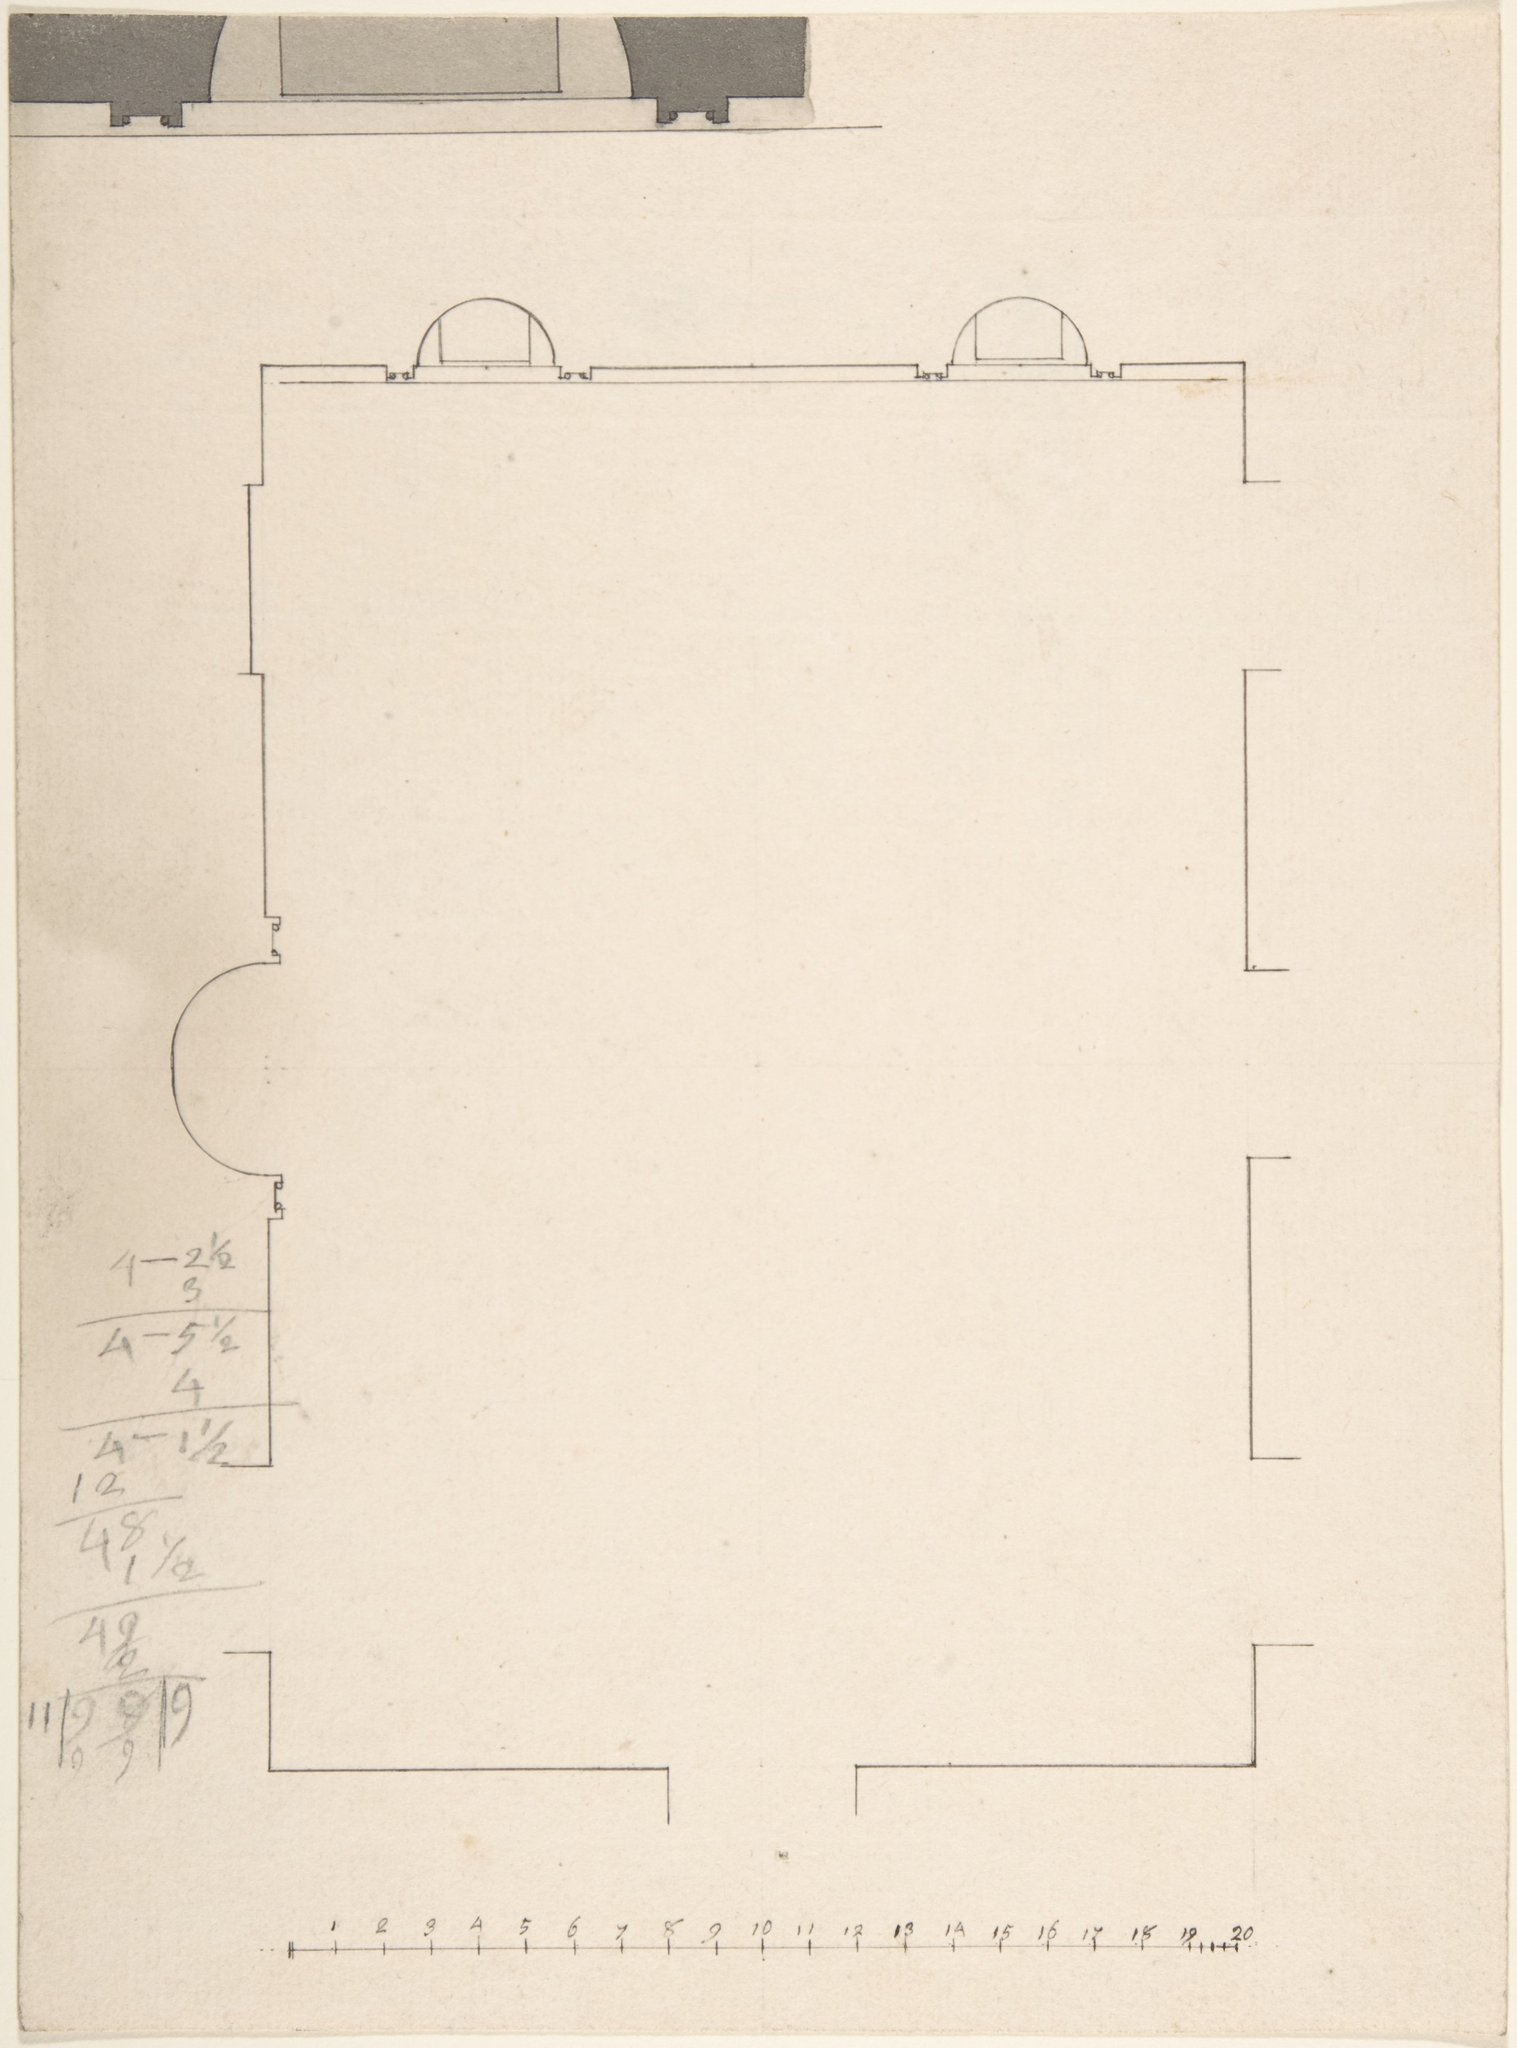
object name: drawing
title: Plan of large room with three niches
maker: anonymous, british, 18th century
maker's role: artist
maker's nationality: british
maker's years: 1700-1800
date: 1701-1800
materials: ink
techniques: pen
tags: architecture